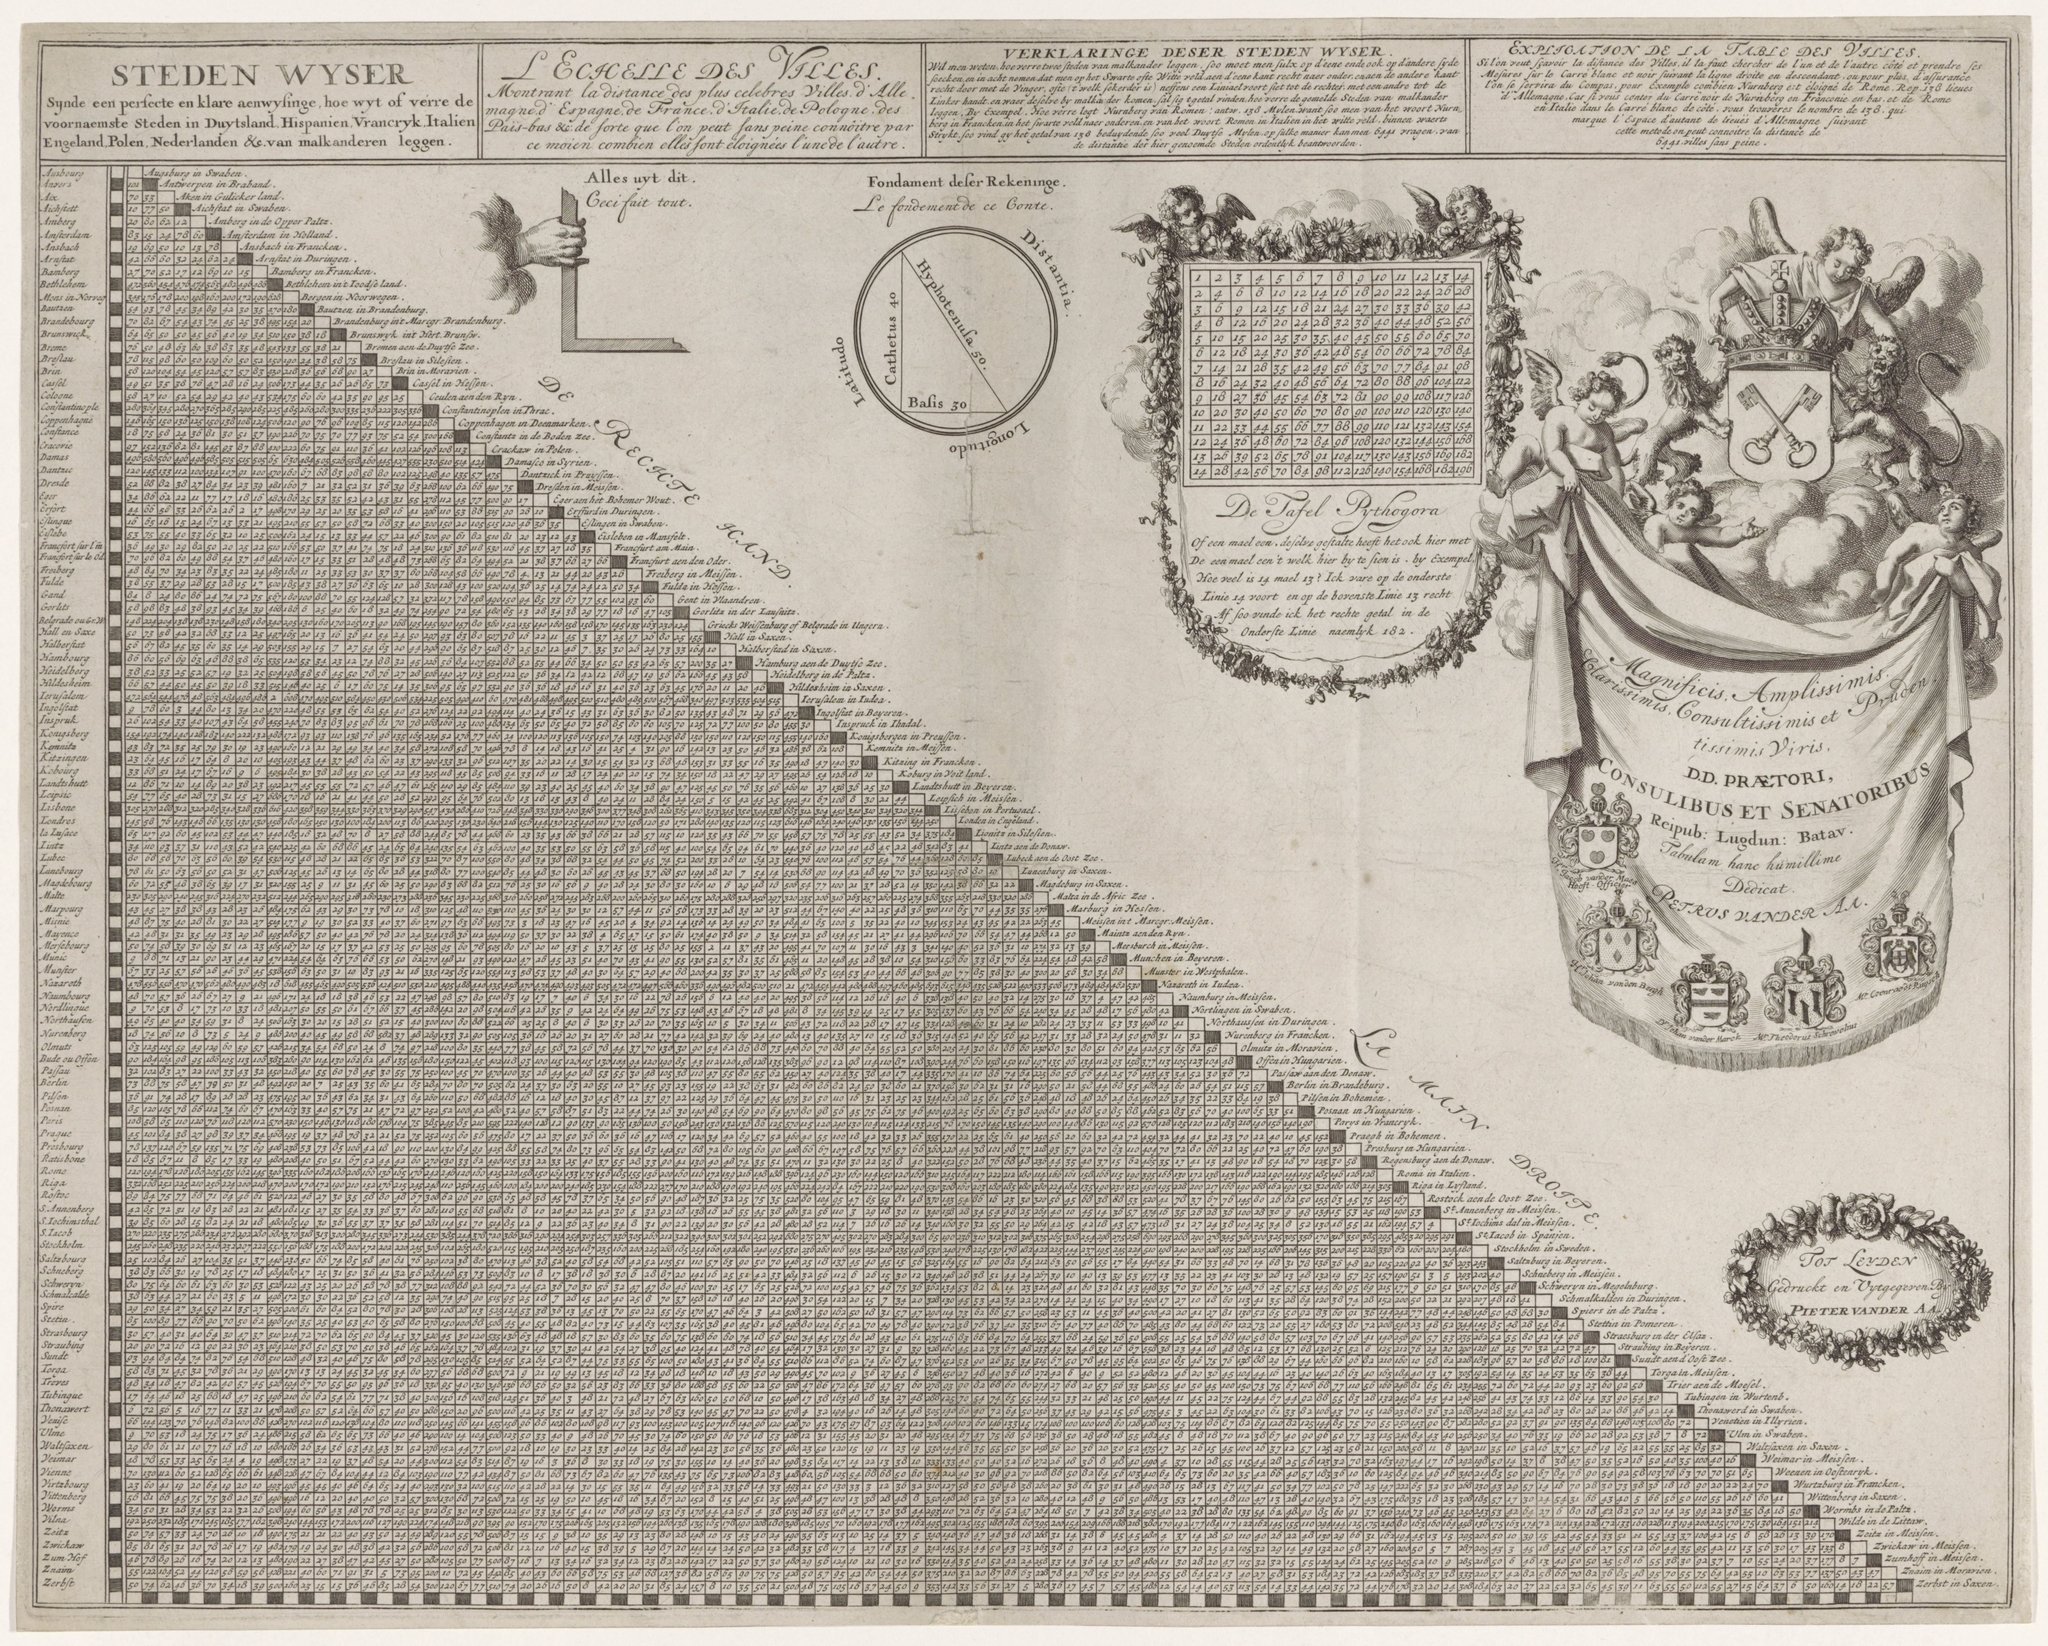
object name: print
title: Afstandstabel voor enkele plaatsen in Europa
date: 1682-1730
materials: paper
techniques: engraving, etching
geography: leiden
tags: compass (+ variant), cupids: 'amores', 'amoretti', 'putti'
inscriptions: collector's mark: Lugt 2228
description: Afstandstabel waarin staat wat de onderlinge afstand is van een aantal belangrijke steden in Duitsland, Spanje, Frankrijk, Italië, Engeland, Polen en Nederland. Bovenaan de gebruiksaanwijzing in het Nederlands en Frans. Rechts de 'Tafel van Pythogora' met een verklaring. Geheel rechts het wapenschild van Leiden, gekroond met de keizerskroon.